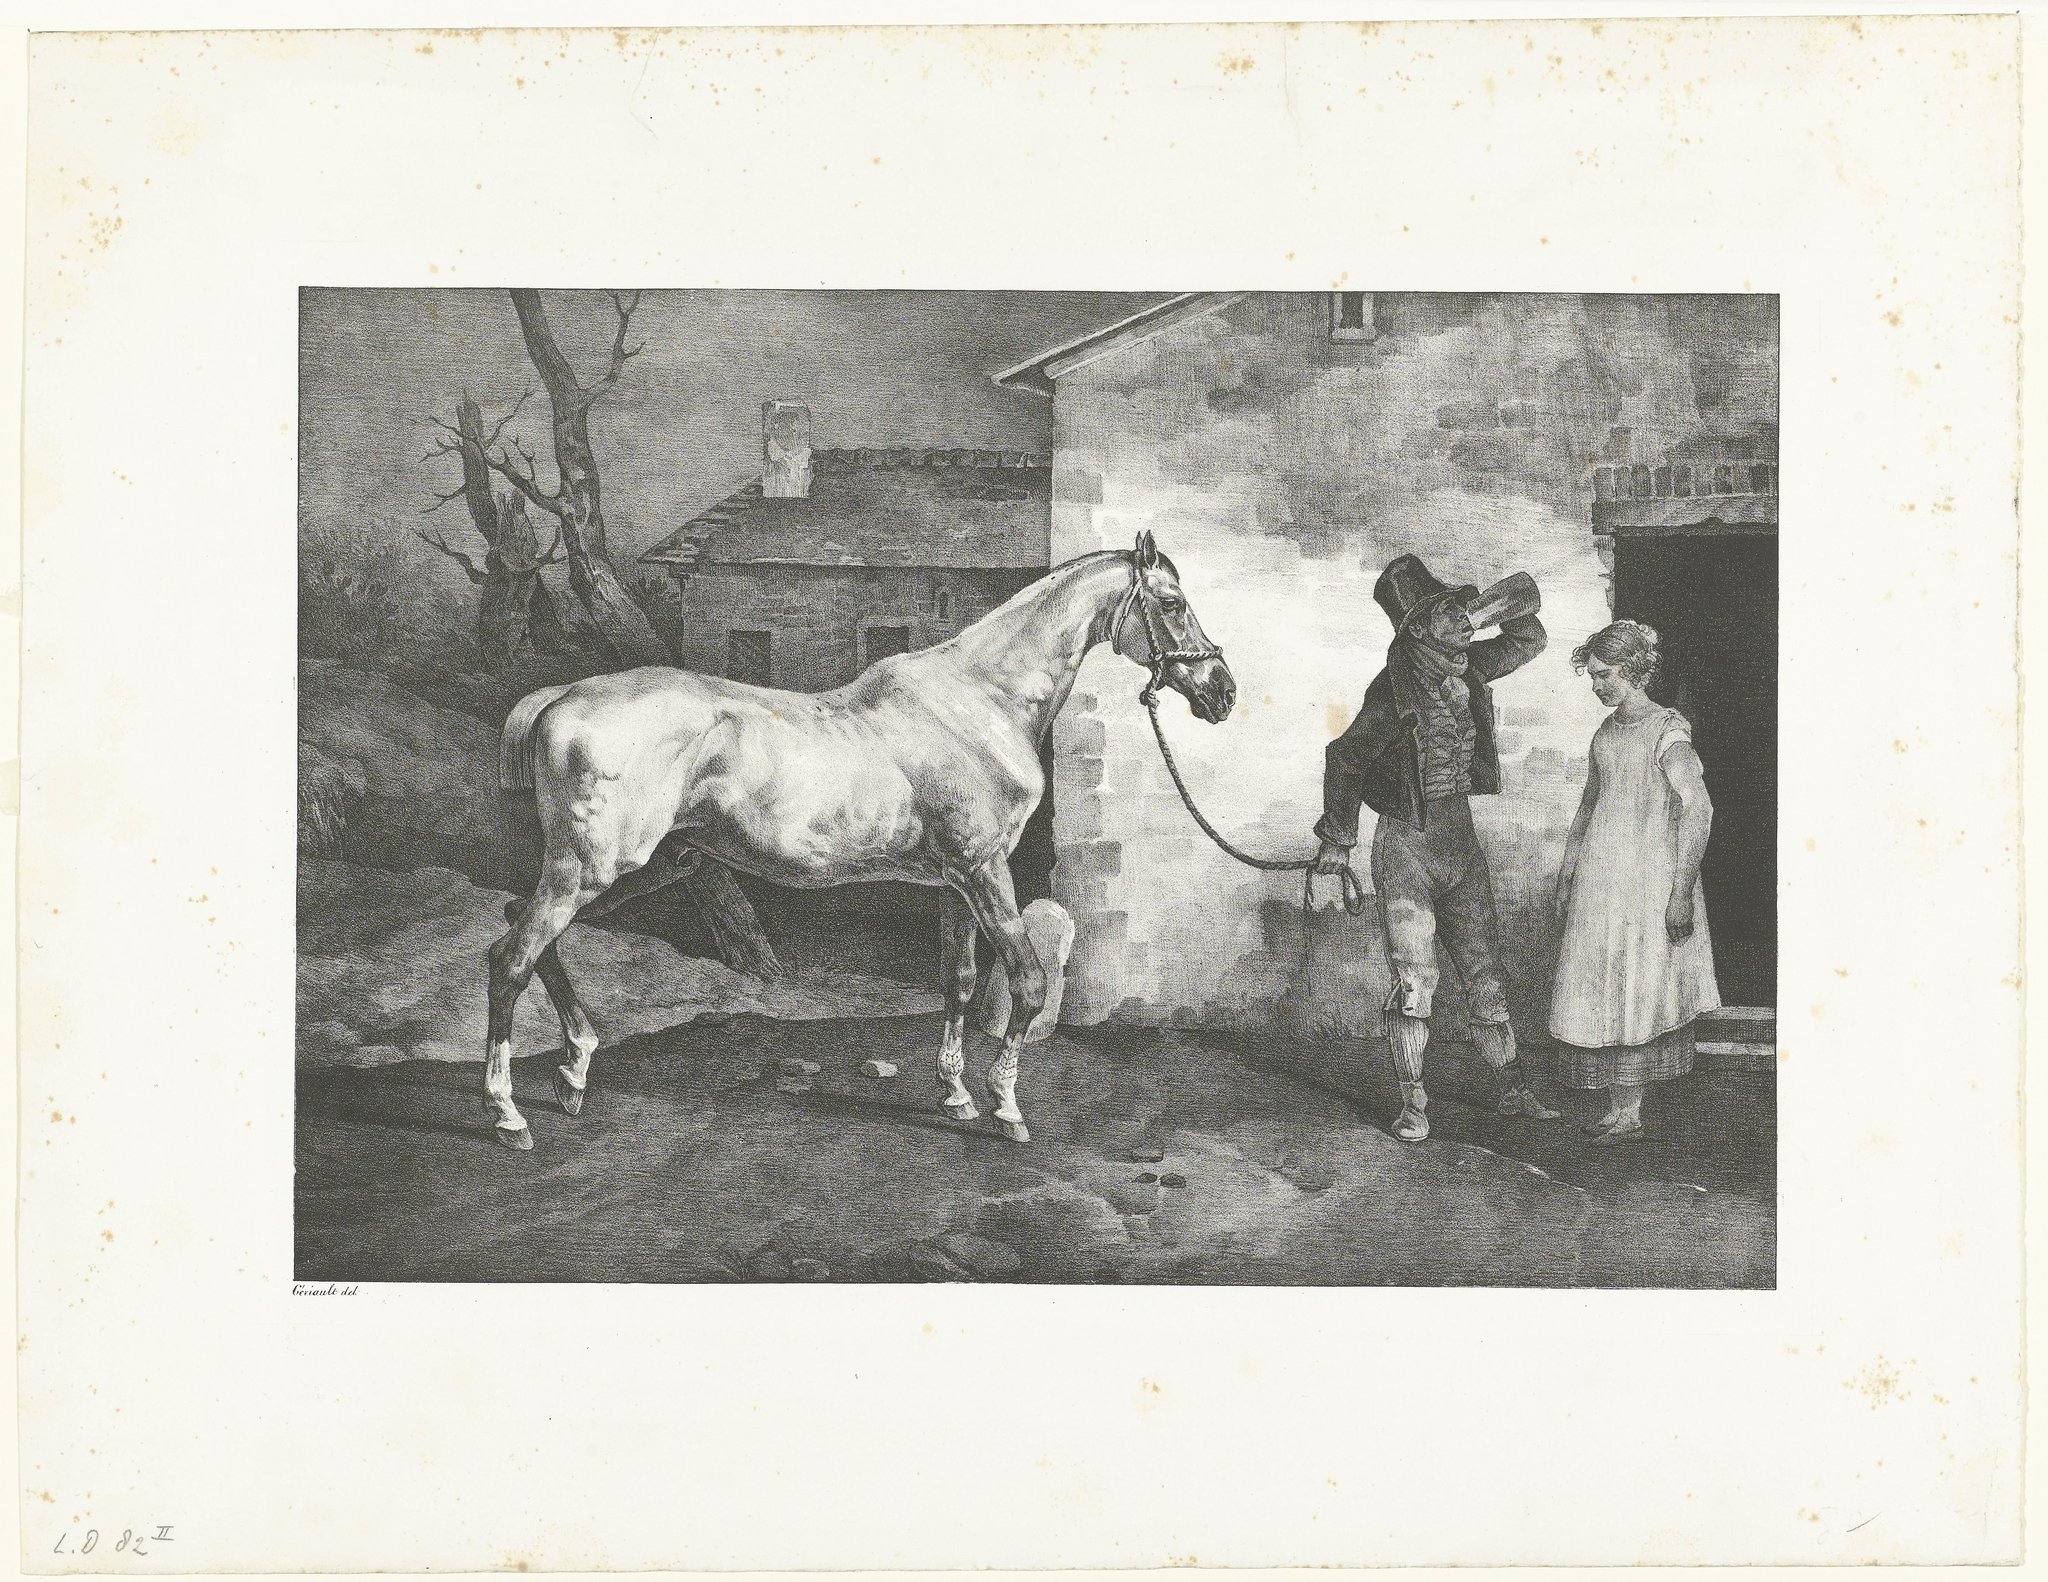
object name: print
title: Verschillende studies van paarden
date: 1822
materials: paper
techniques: lithograph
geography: paris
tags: inn, coffee-house, public house, etc., horse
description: Een man staat met zijn paard aan een touw bij een herberg. Hij drinkt uit een beker, naast hem een meisje. Uit een serie van twaalf prenten.